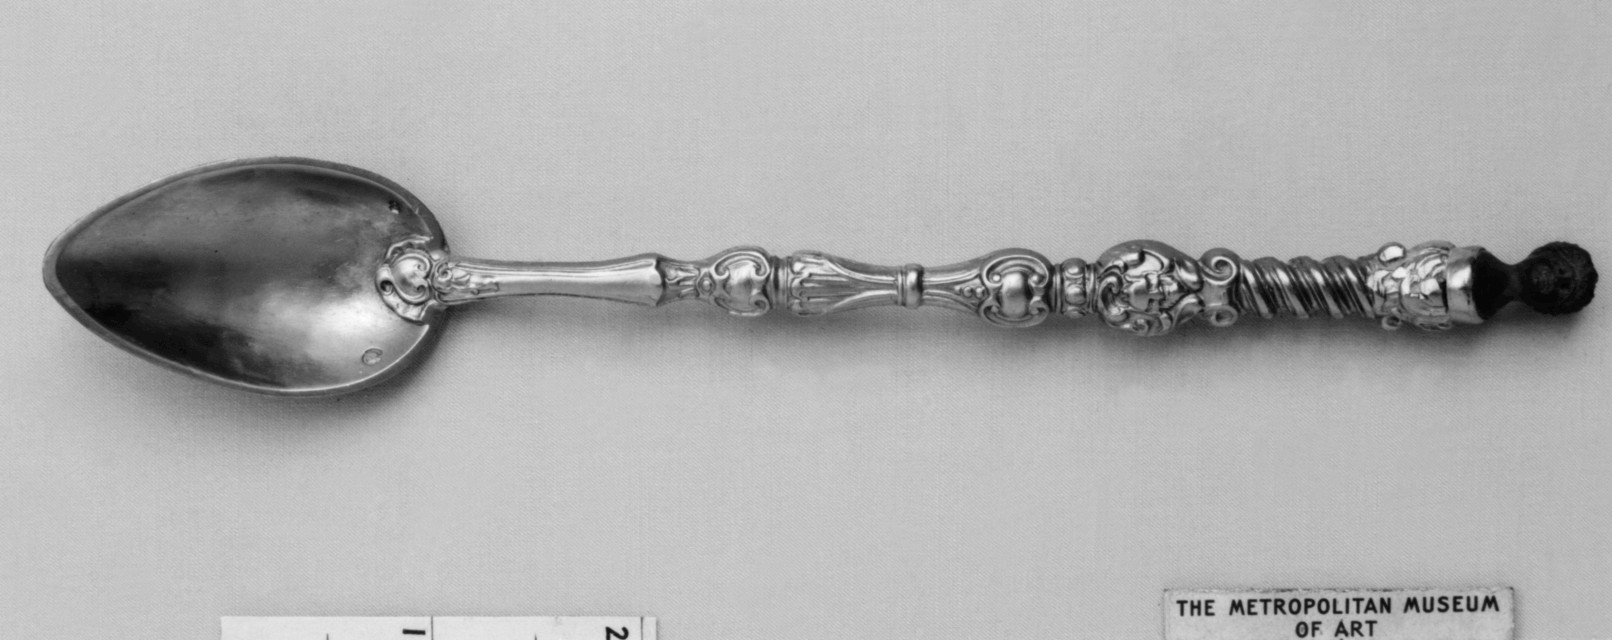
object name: spoon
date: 1801-1900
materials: coral, silver gilt